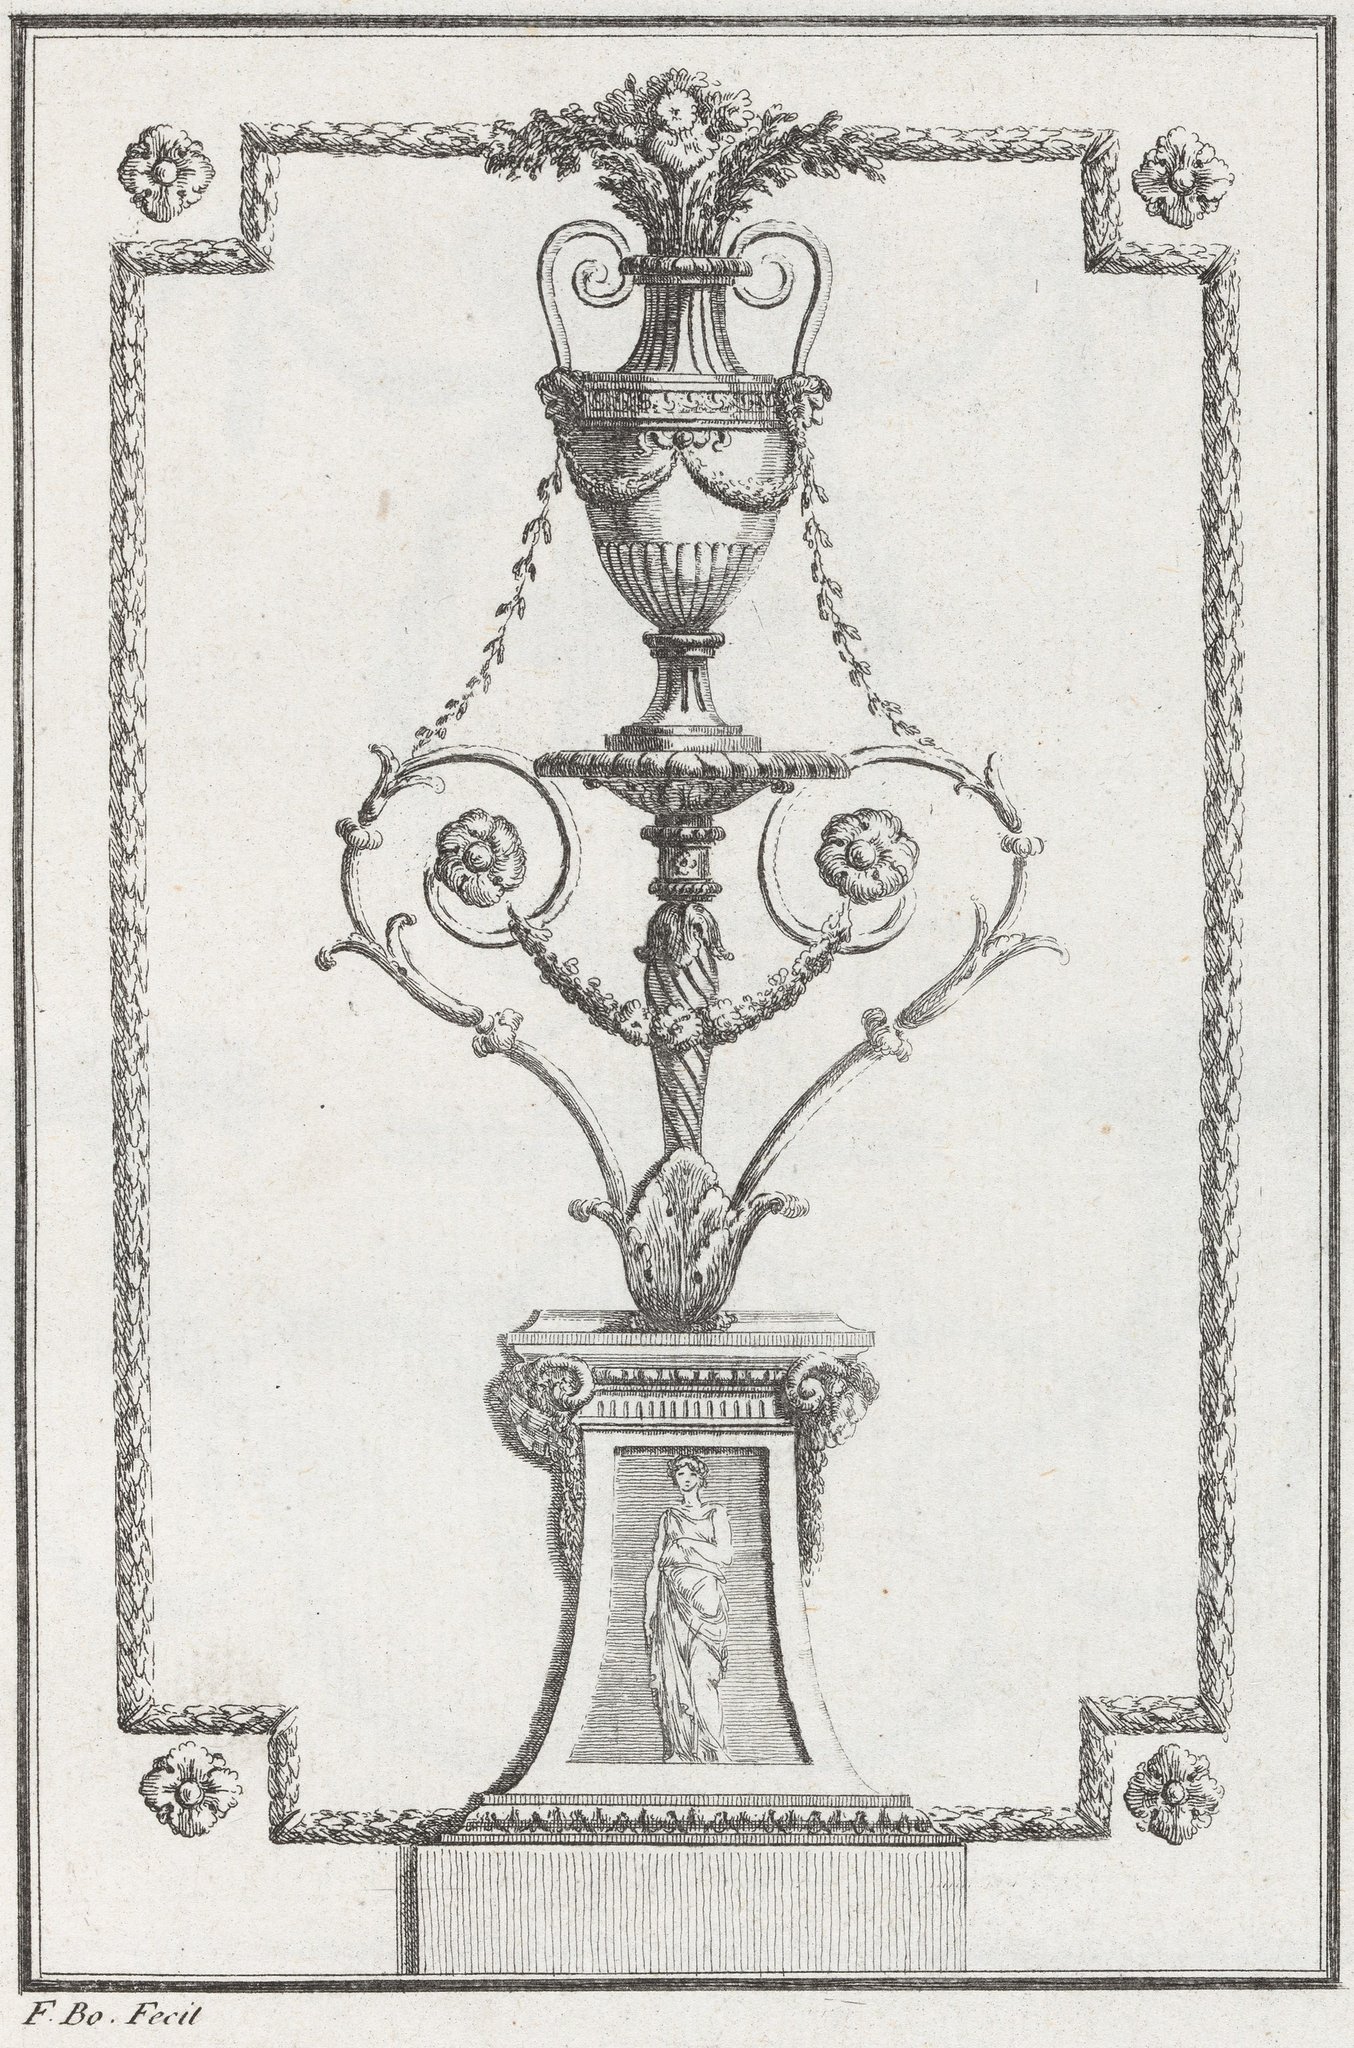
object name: book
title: VIIIe Cahier d'Arabesques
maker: juste nathan boucher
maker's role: designer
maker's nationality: french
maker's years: 1736-1782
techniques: etching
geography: france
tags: human figures